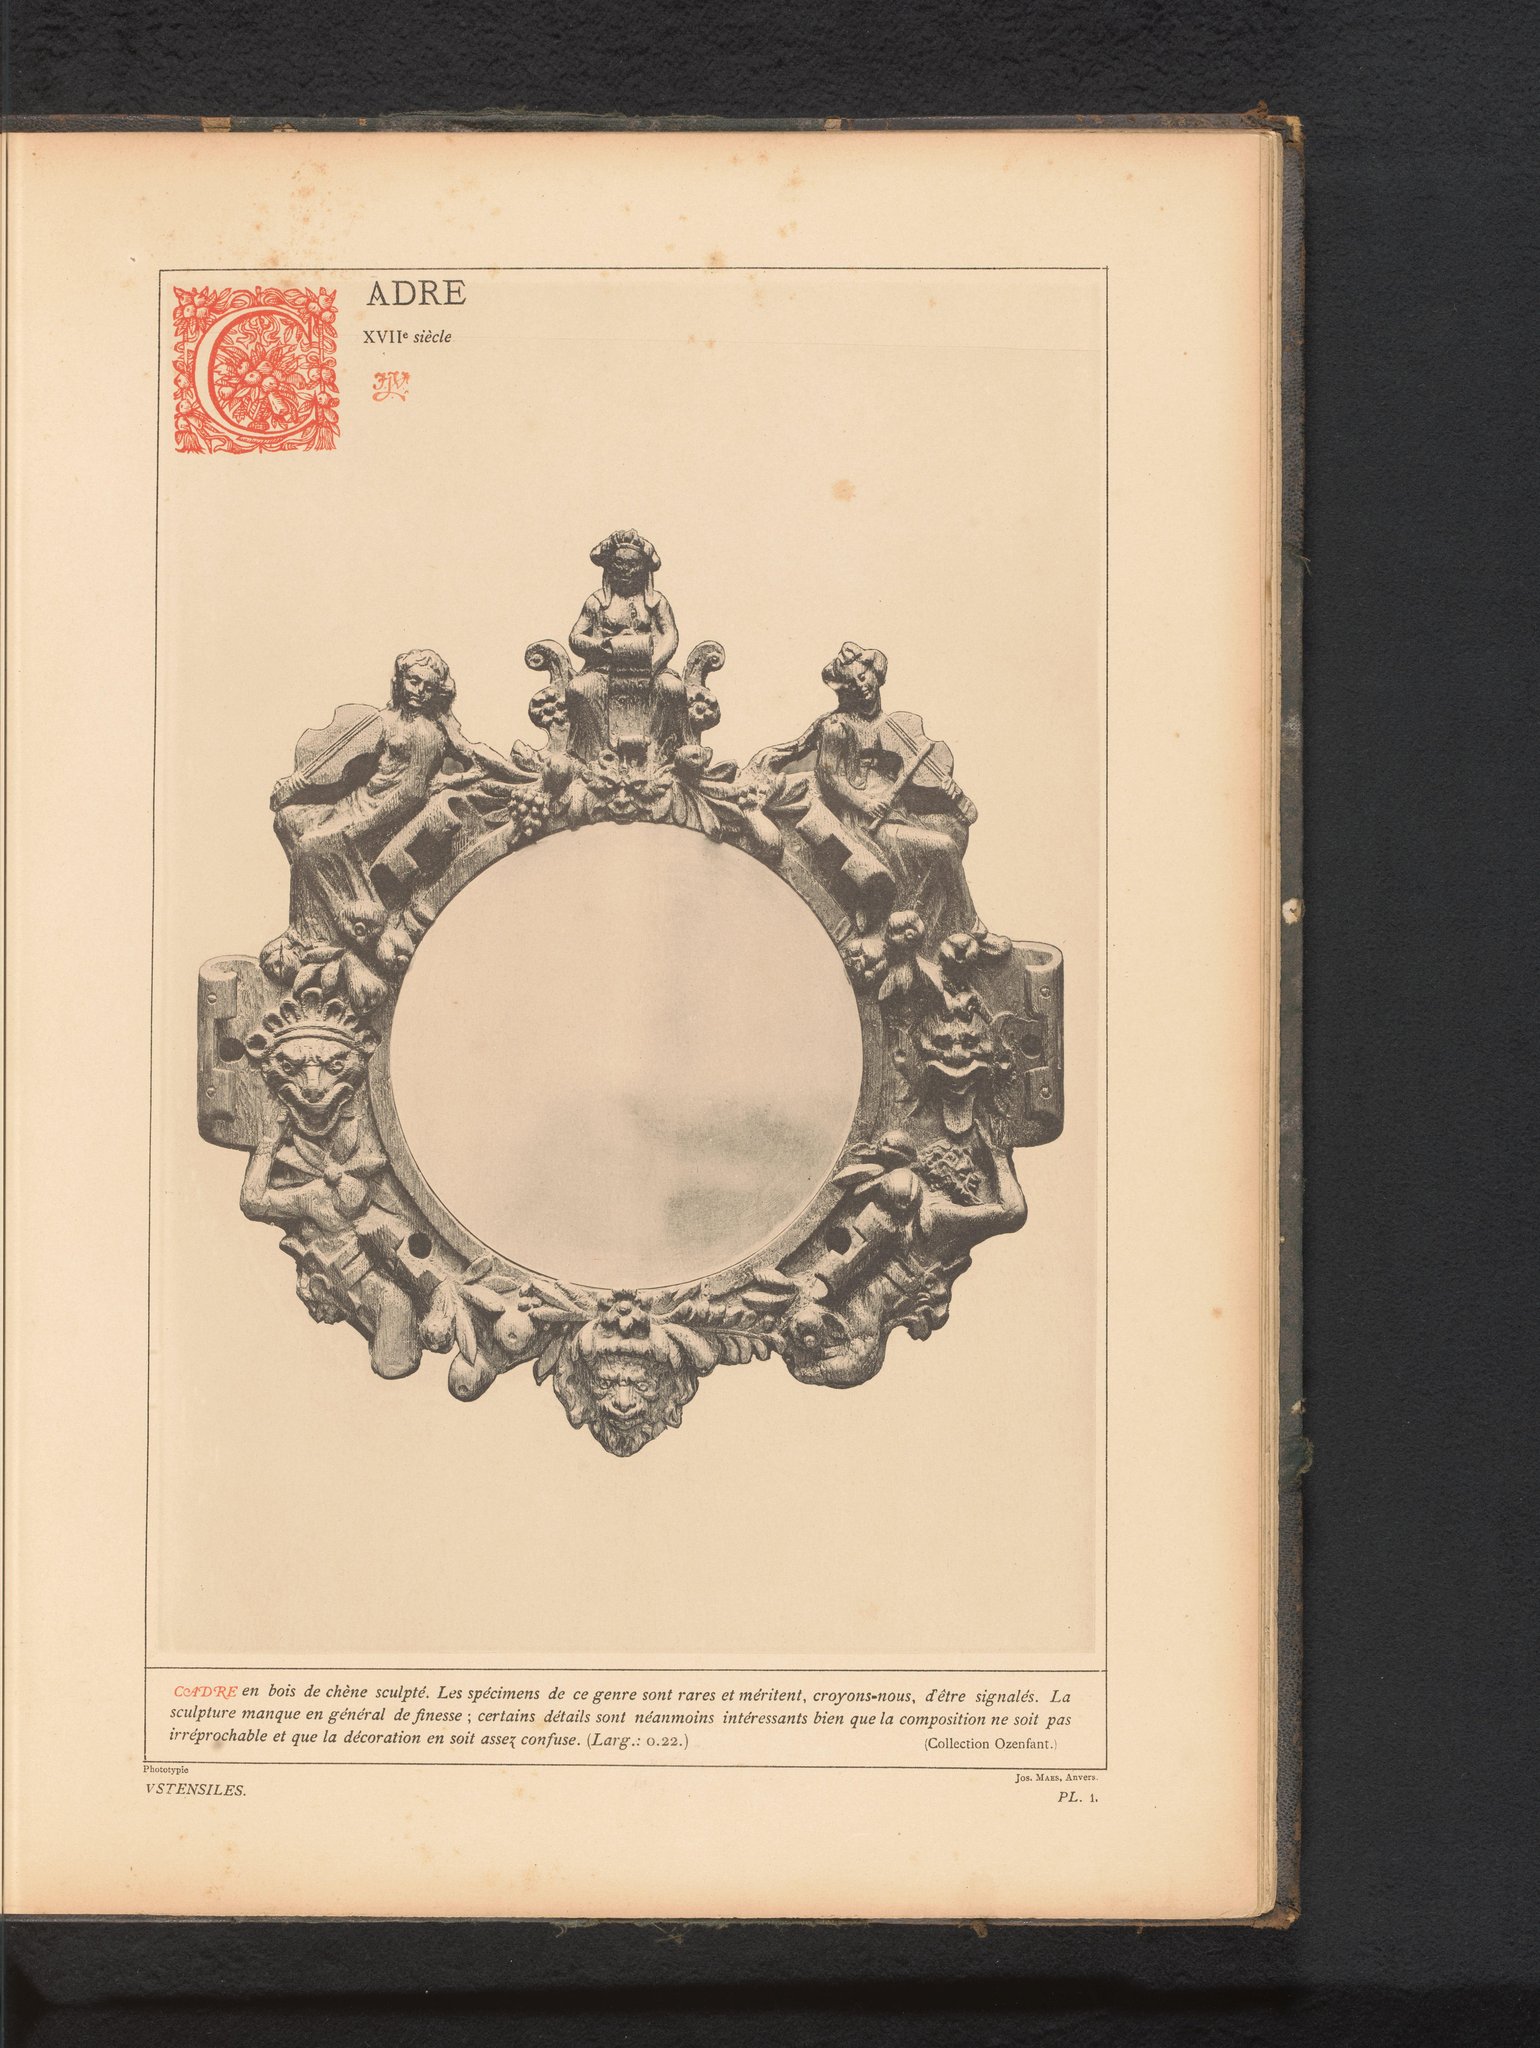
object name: page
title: Gedecoreerde lijst van eikenhout met musicerende figuren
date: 1882-1887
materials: paper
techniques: photograph, photolithography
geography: belgium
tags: making music; musician with instrument, frame of painting, etc.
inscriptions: inscription: ‘UTENSILES. - PL. 1.’, inscription: ‘CADRE en bois (...)’, monogram: ‘JJvY’